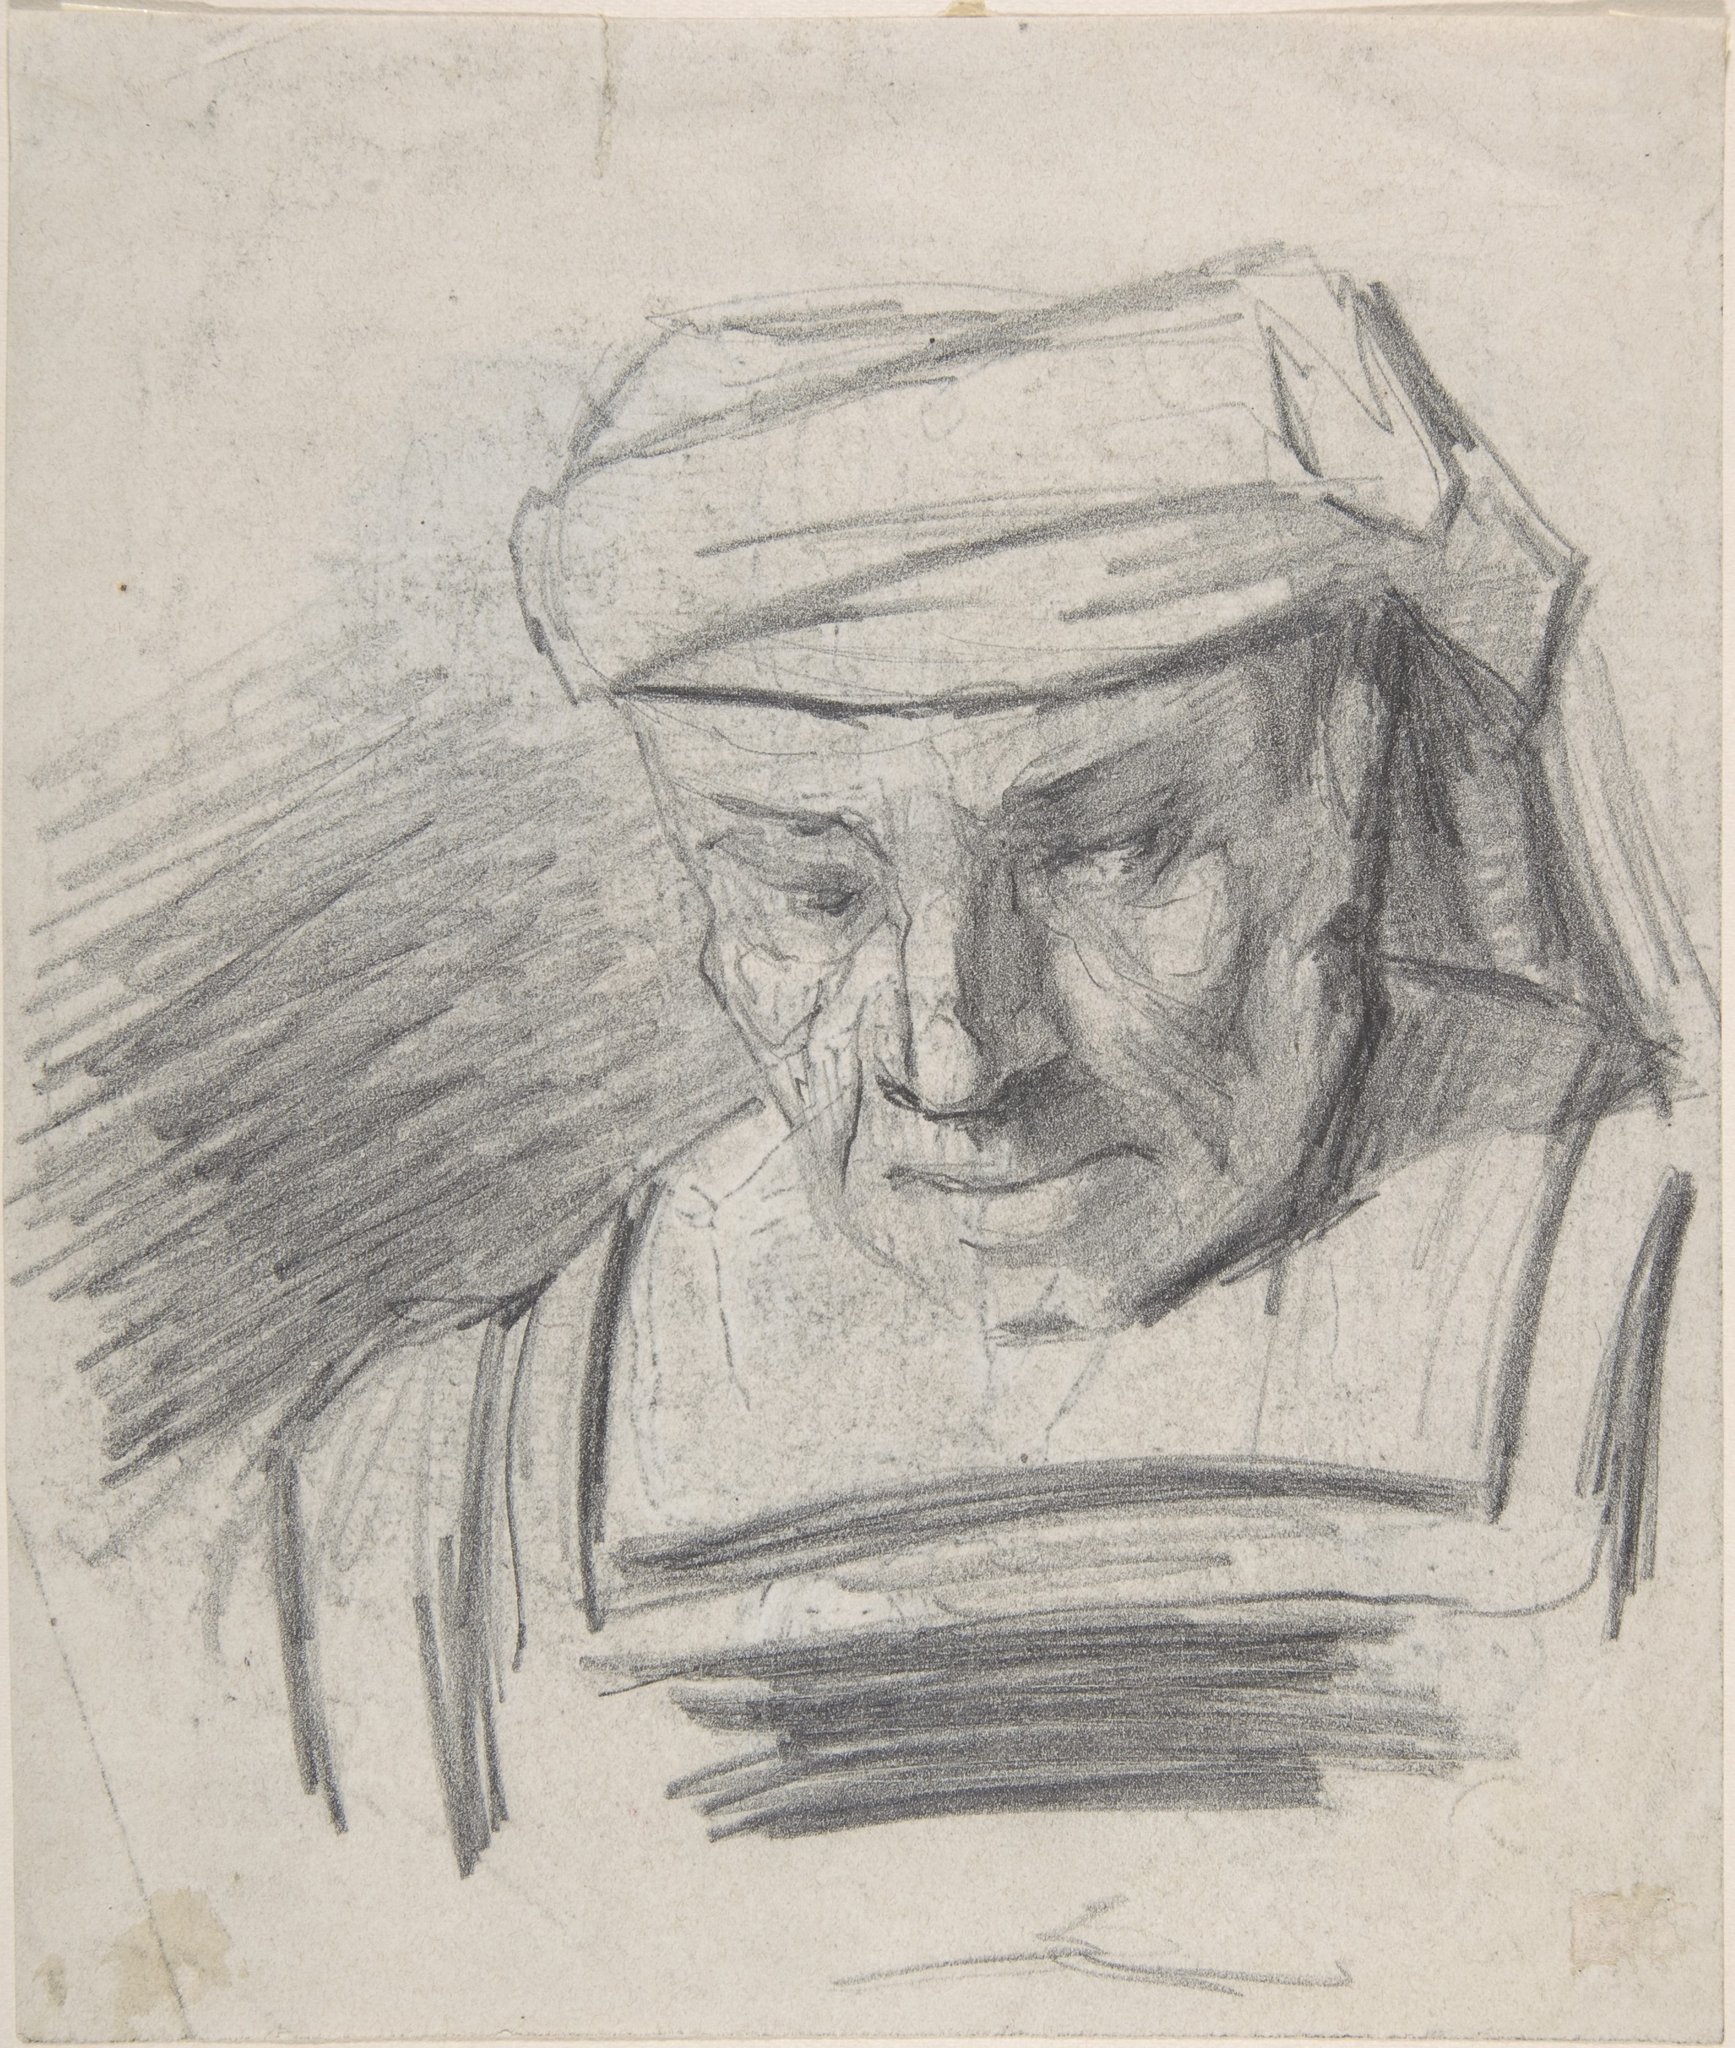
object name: drawing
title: Head of a figure wearing a turban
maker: félicien rops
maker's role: artist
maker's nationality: belgian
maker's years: 1833-1898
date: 1833-1898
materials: graphite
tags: heads,men,portraits